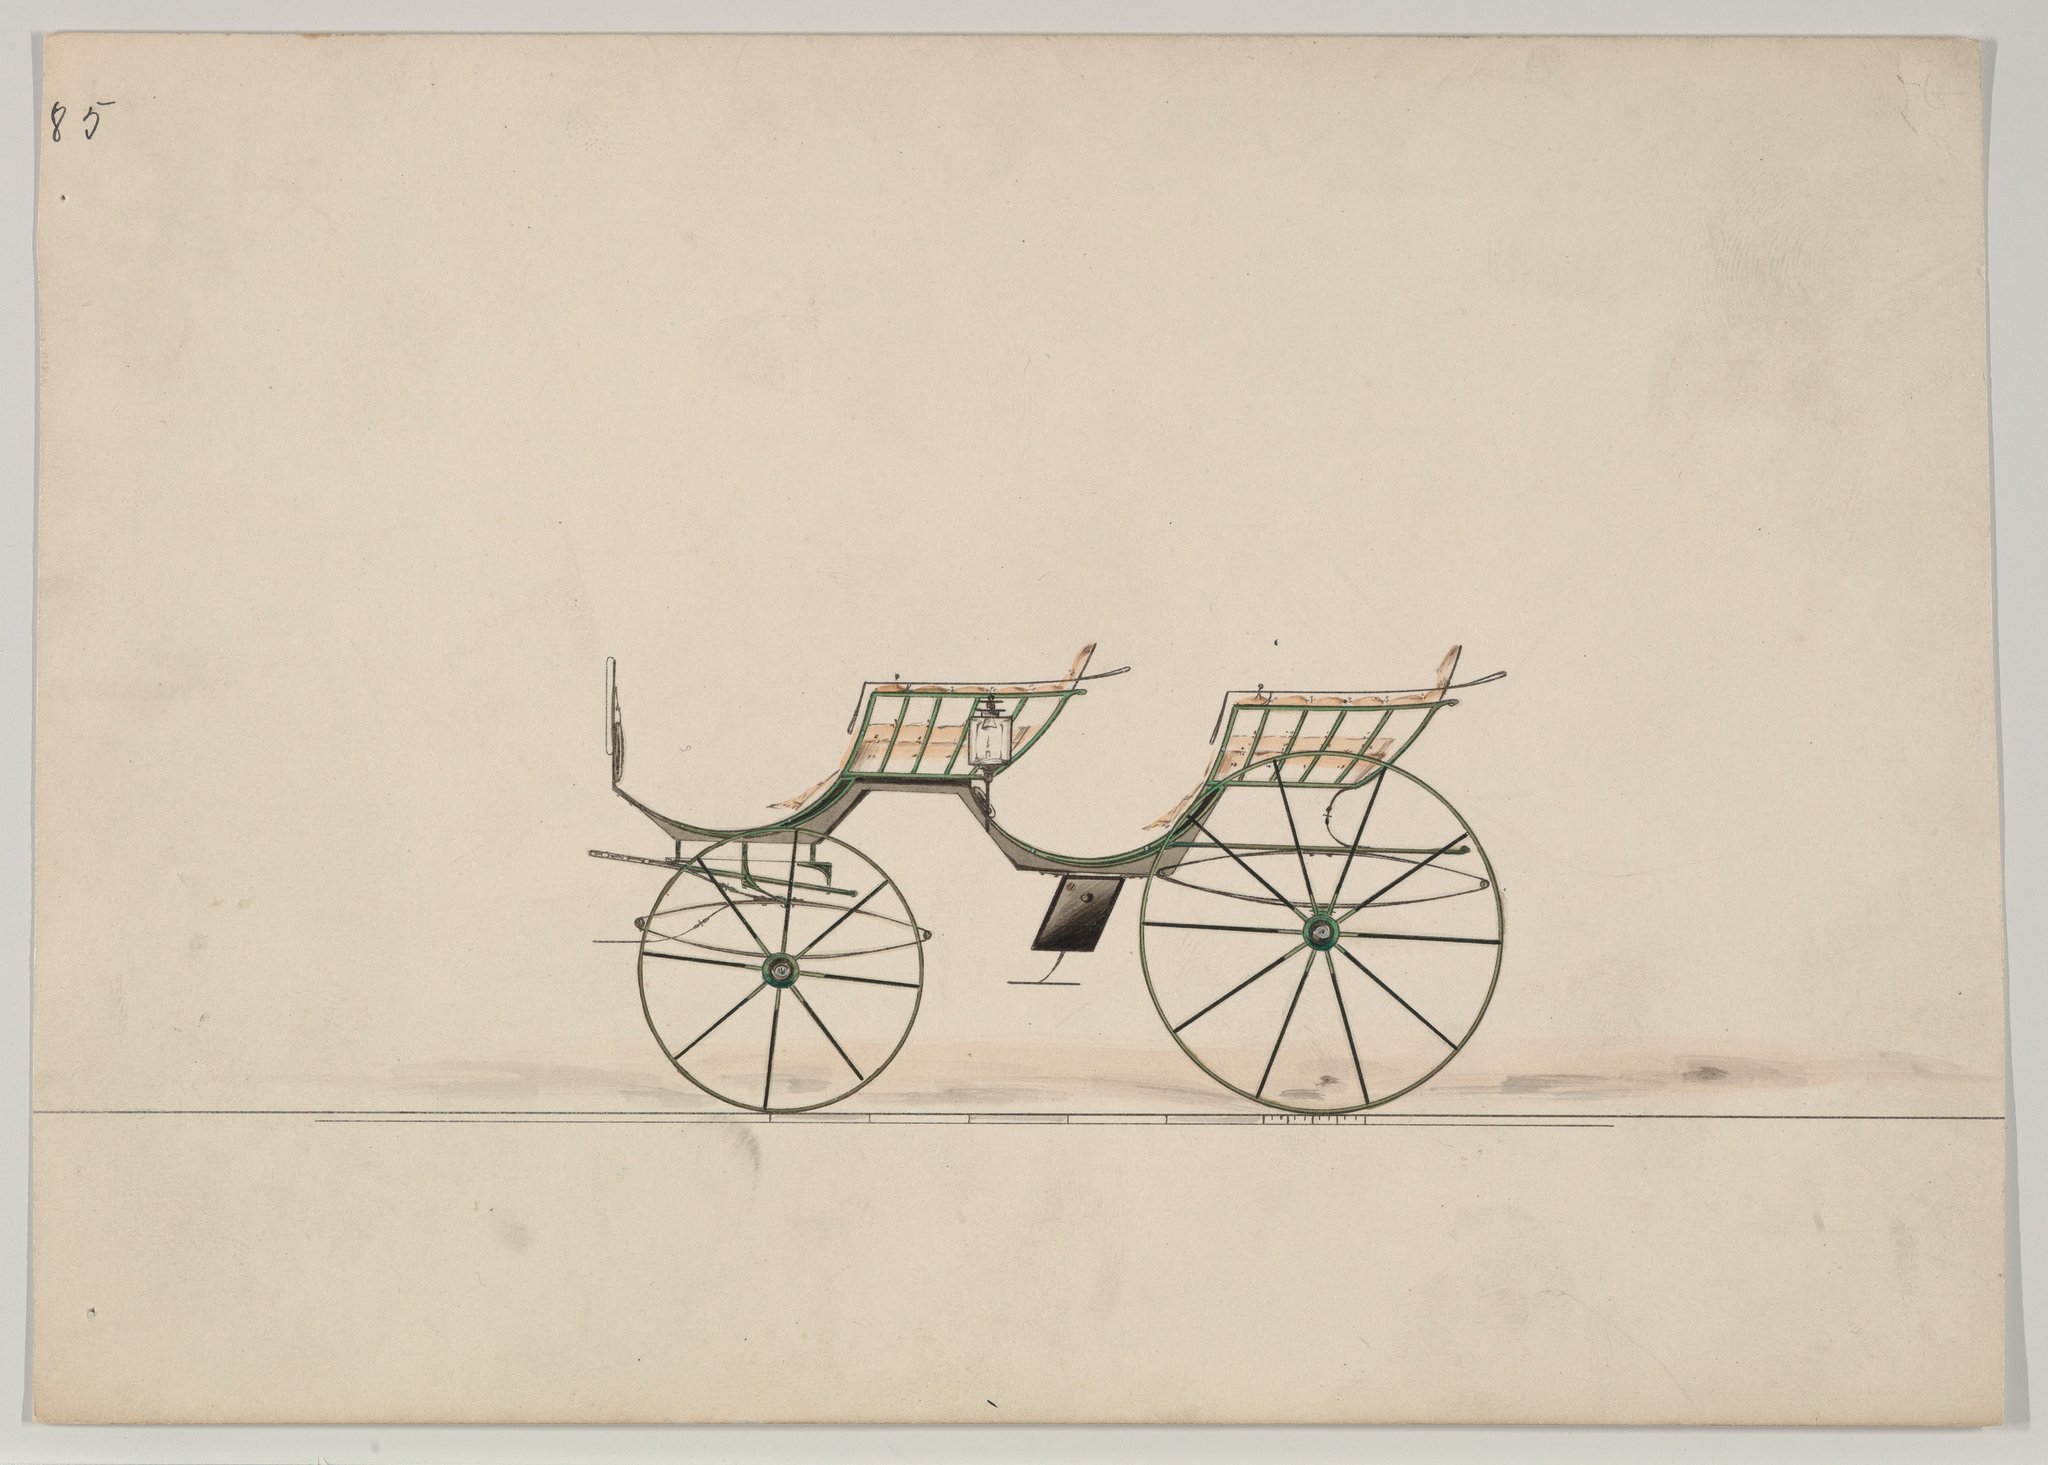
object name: drawing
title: Phaeton (unnumbered)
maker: brewster & co.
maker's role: manufacturer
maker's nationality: american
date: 1850-1870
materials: gouache, gum arabic, ink, watercolor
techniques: pen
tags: carriages